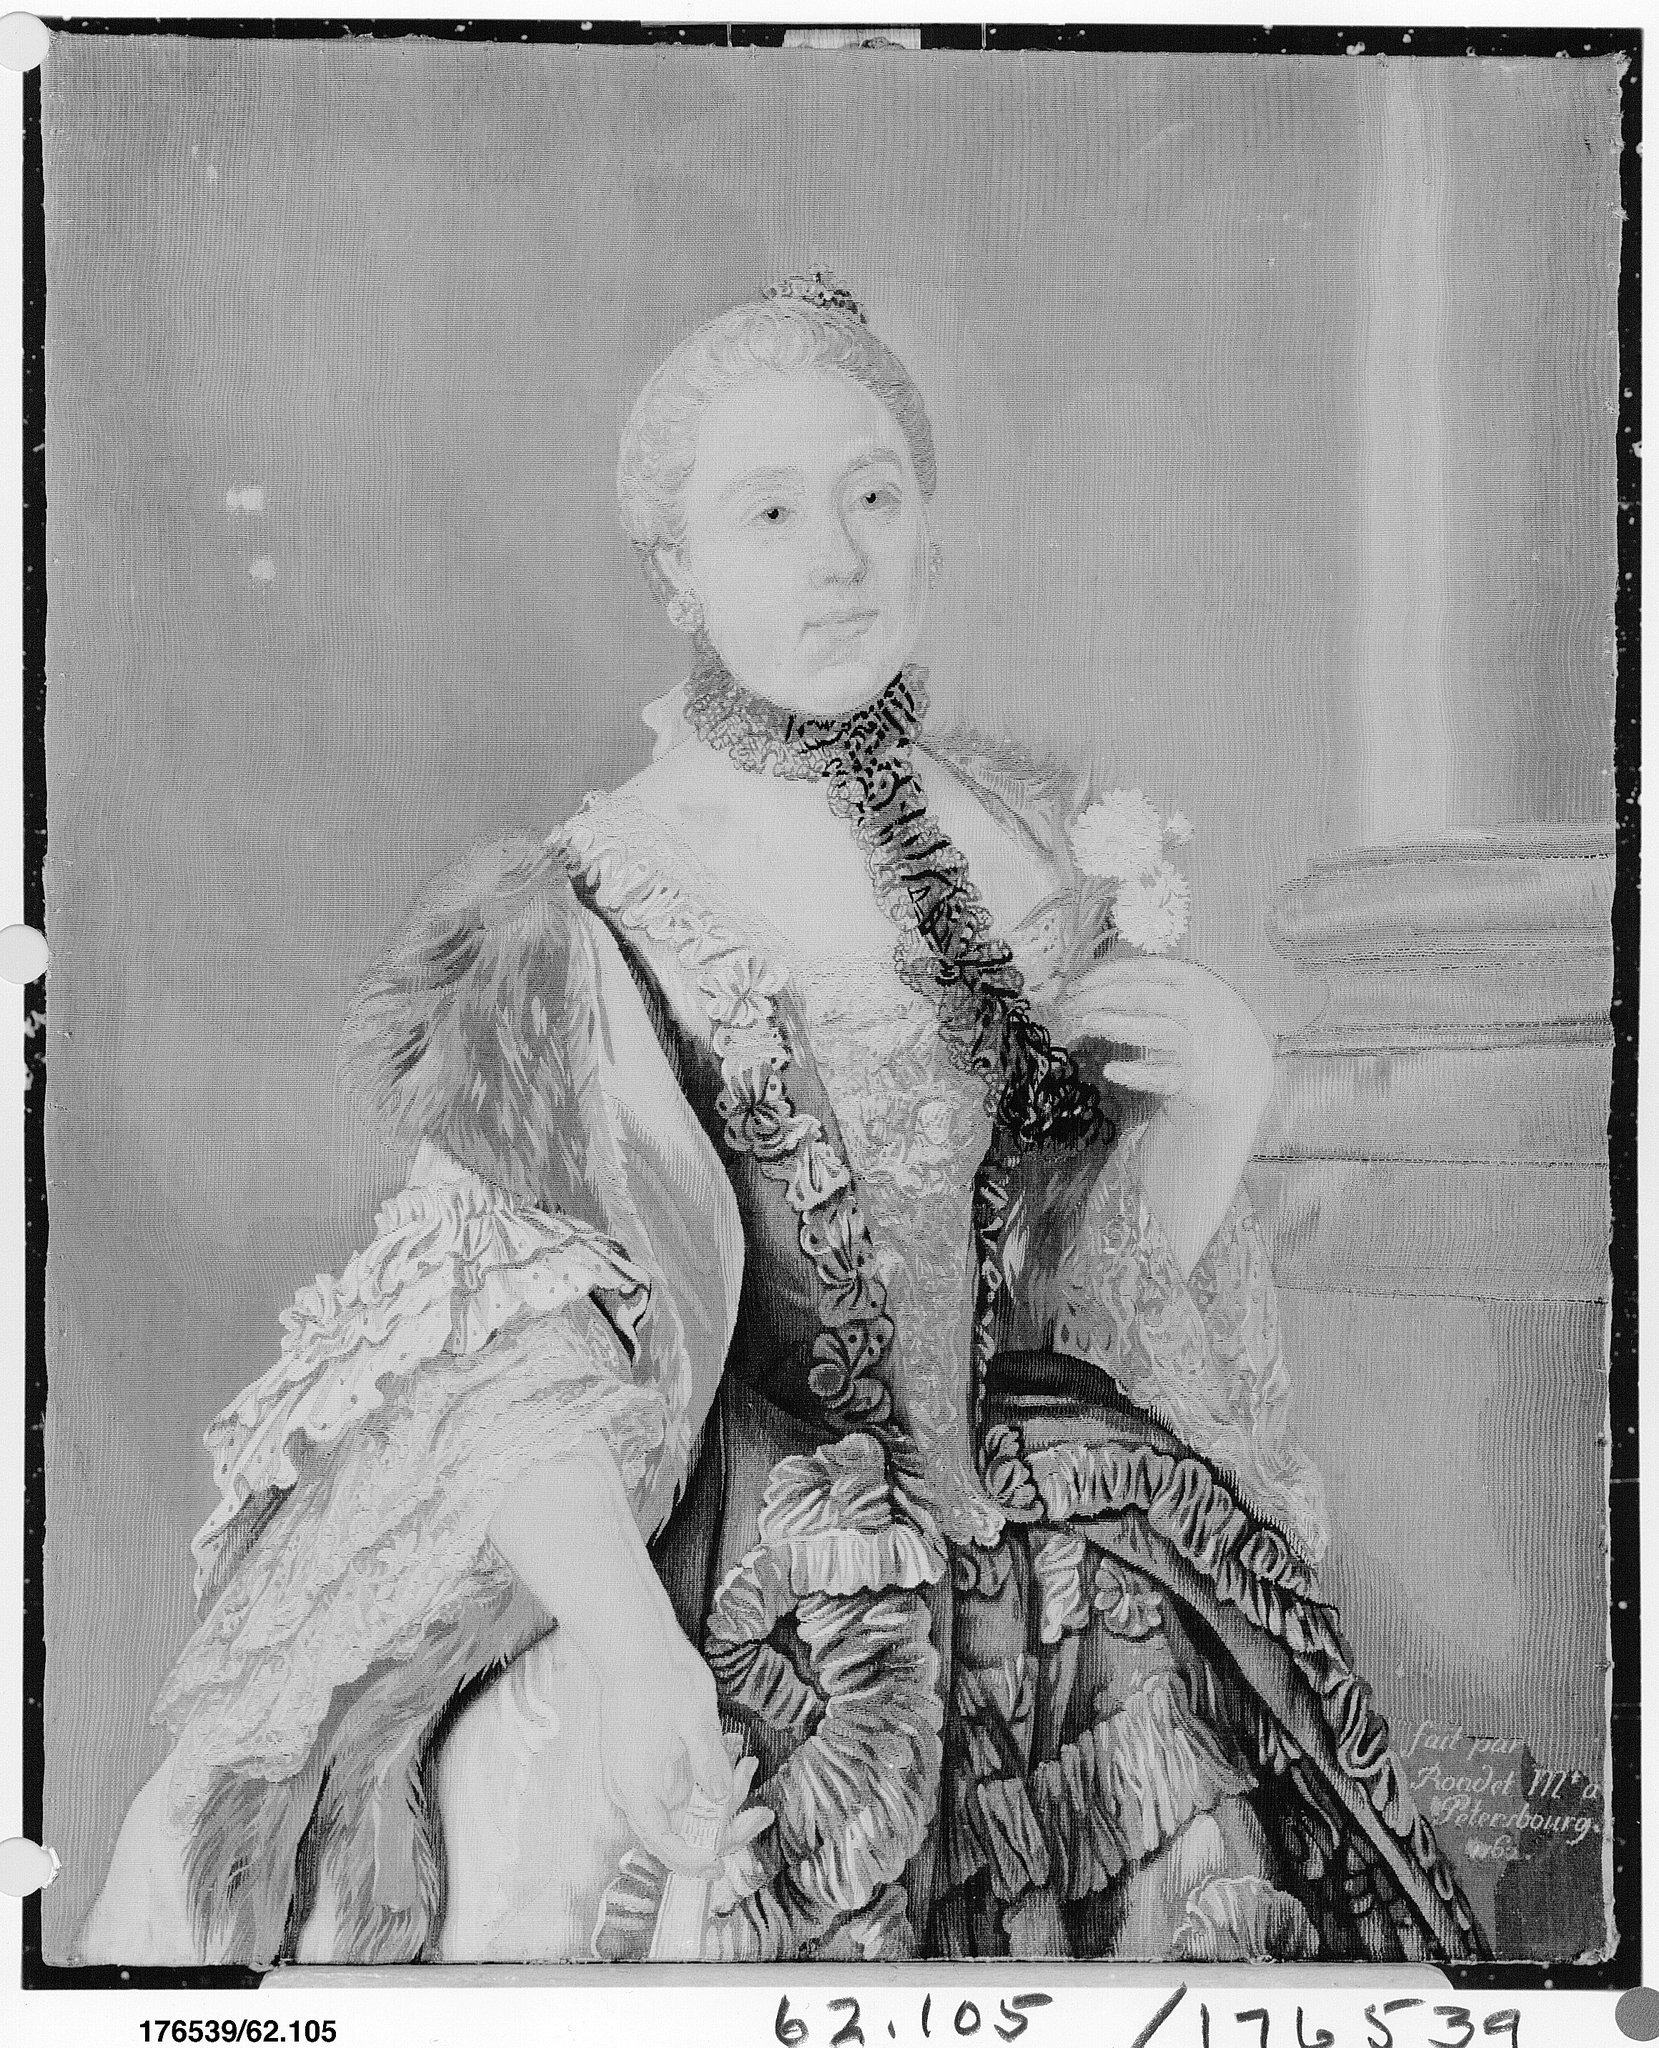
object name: tapestry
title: Portrait of Countess Elizaveta Romanovna Vorontsova (1739–1792)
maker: imperial russian tapestry manufactory, saint petersburg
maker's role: manufactory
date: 1762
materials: silk, wool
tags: portraits,women